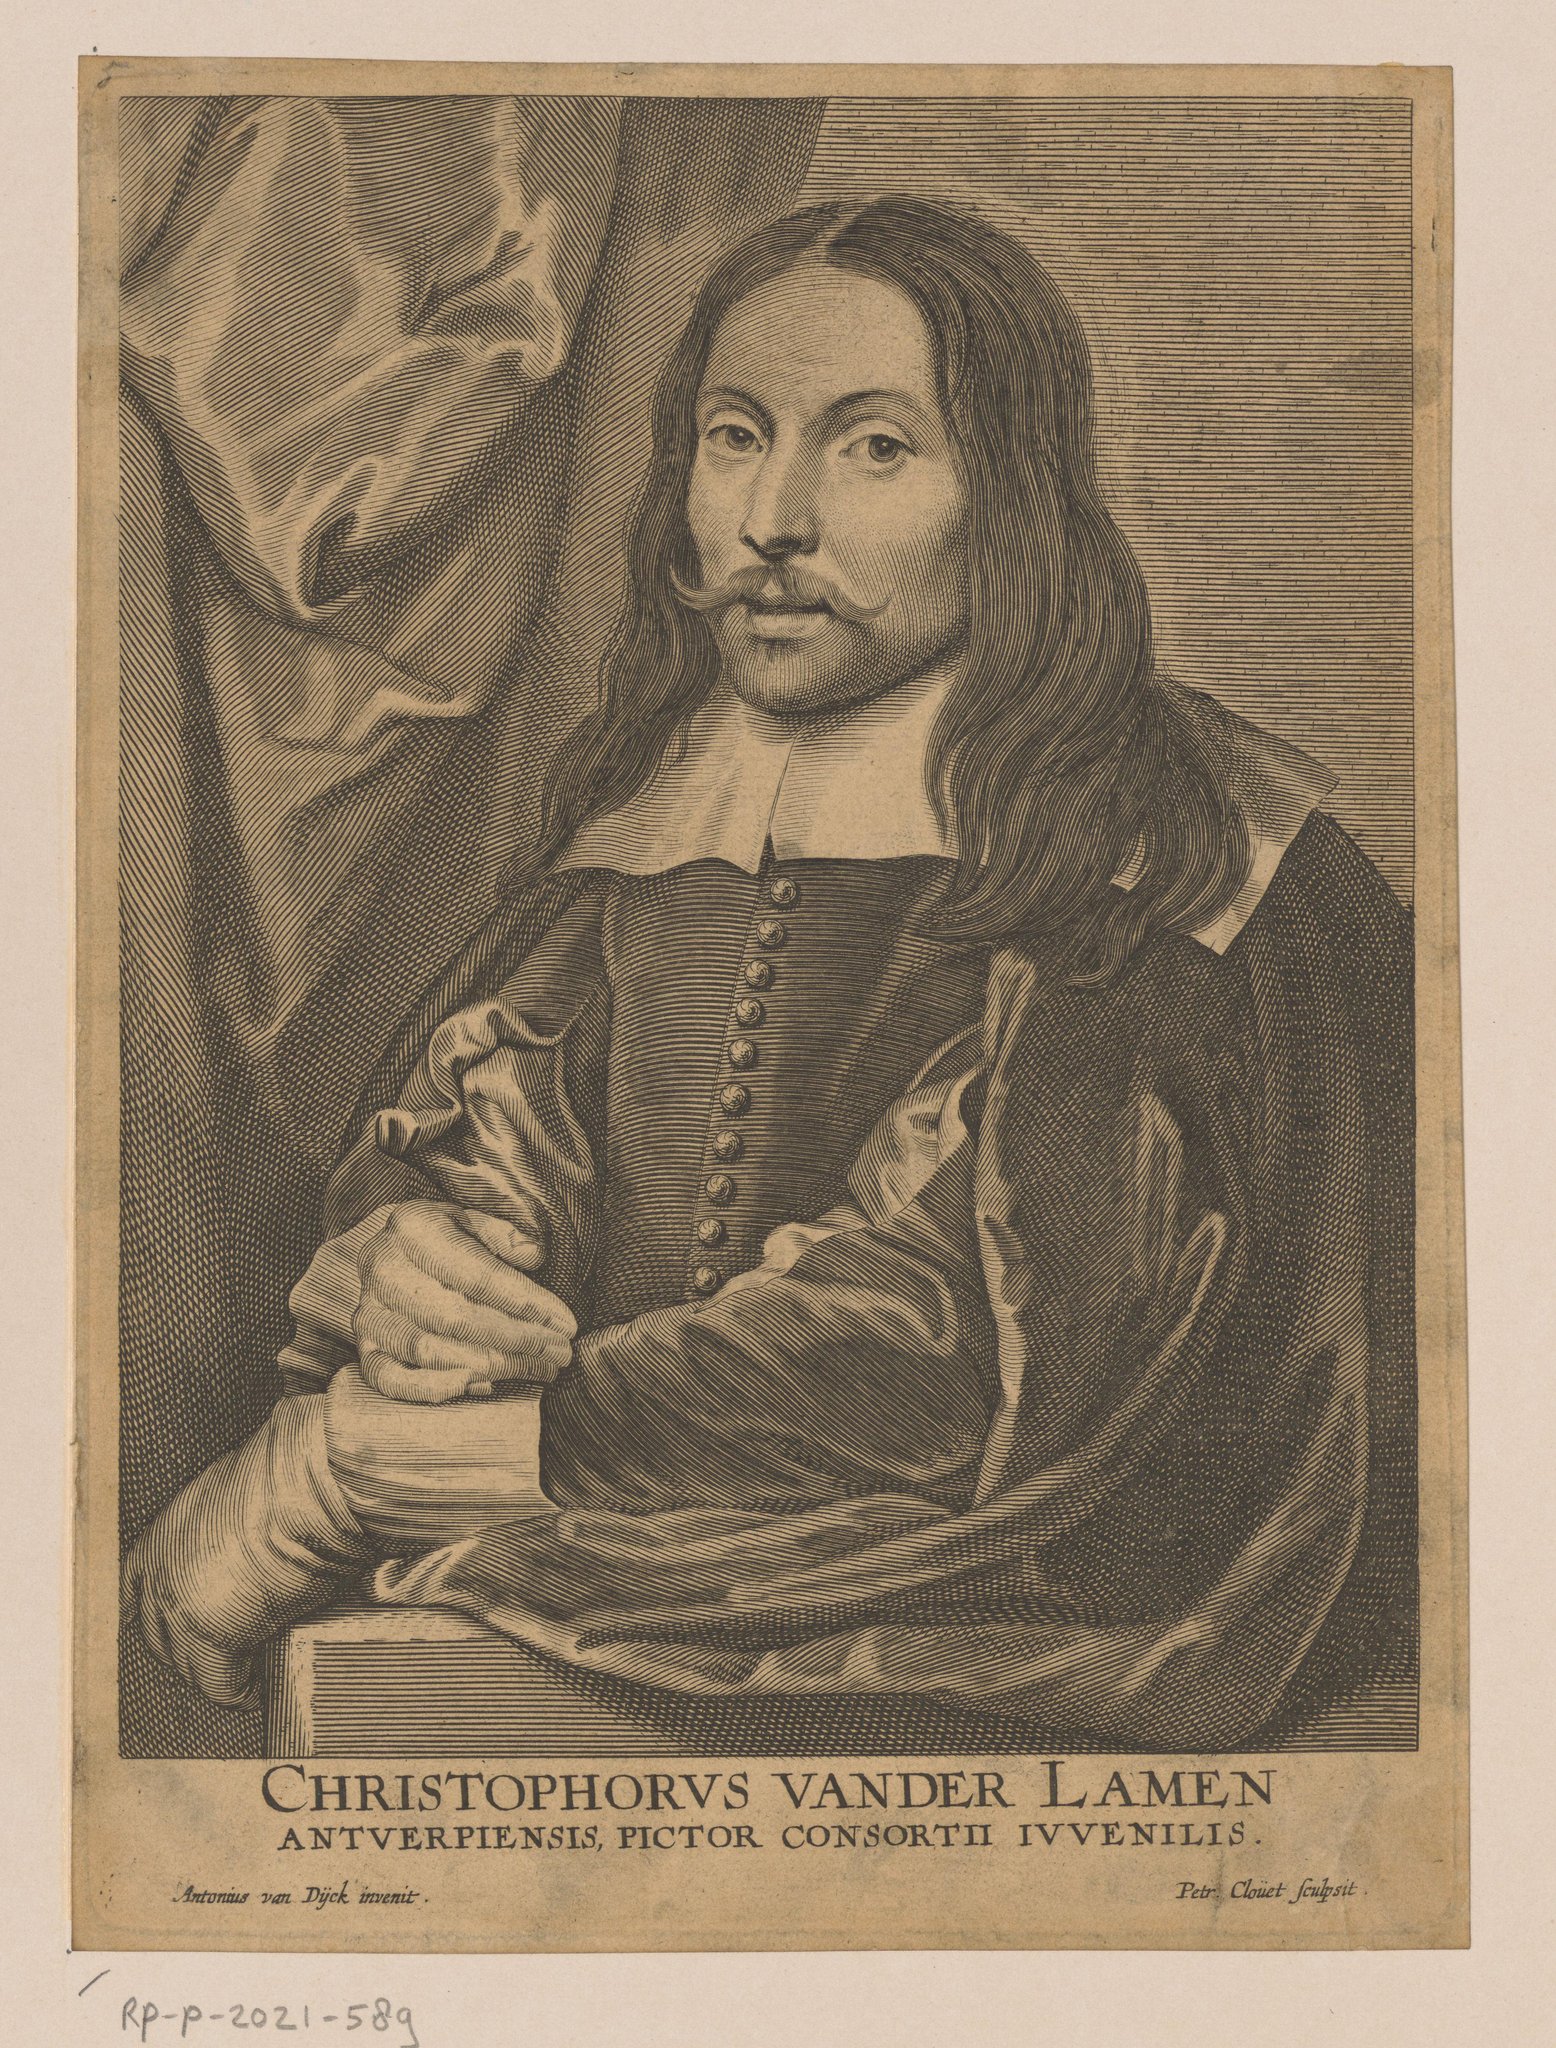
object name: print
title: Icones principum virorum (...)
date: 1640-1645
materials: paper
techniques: engraving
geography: antwerp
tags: painter, christoffel van der lamen, historical persons, portrait, self-portrait of painter